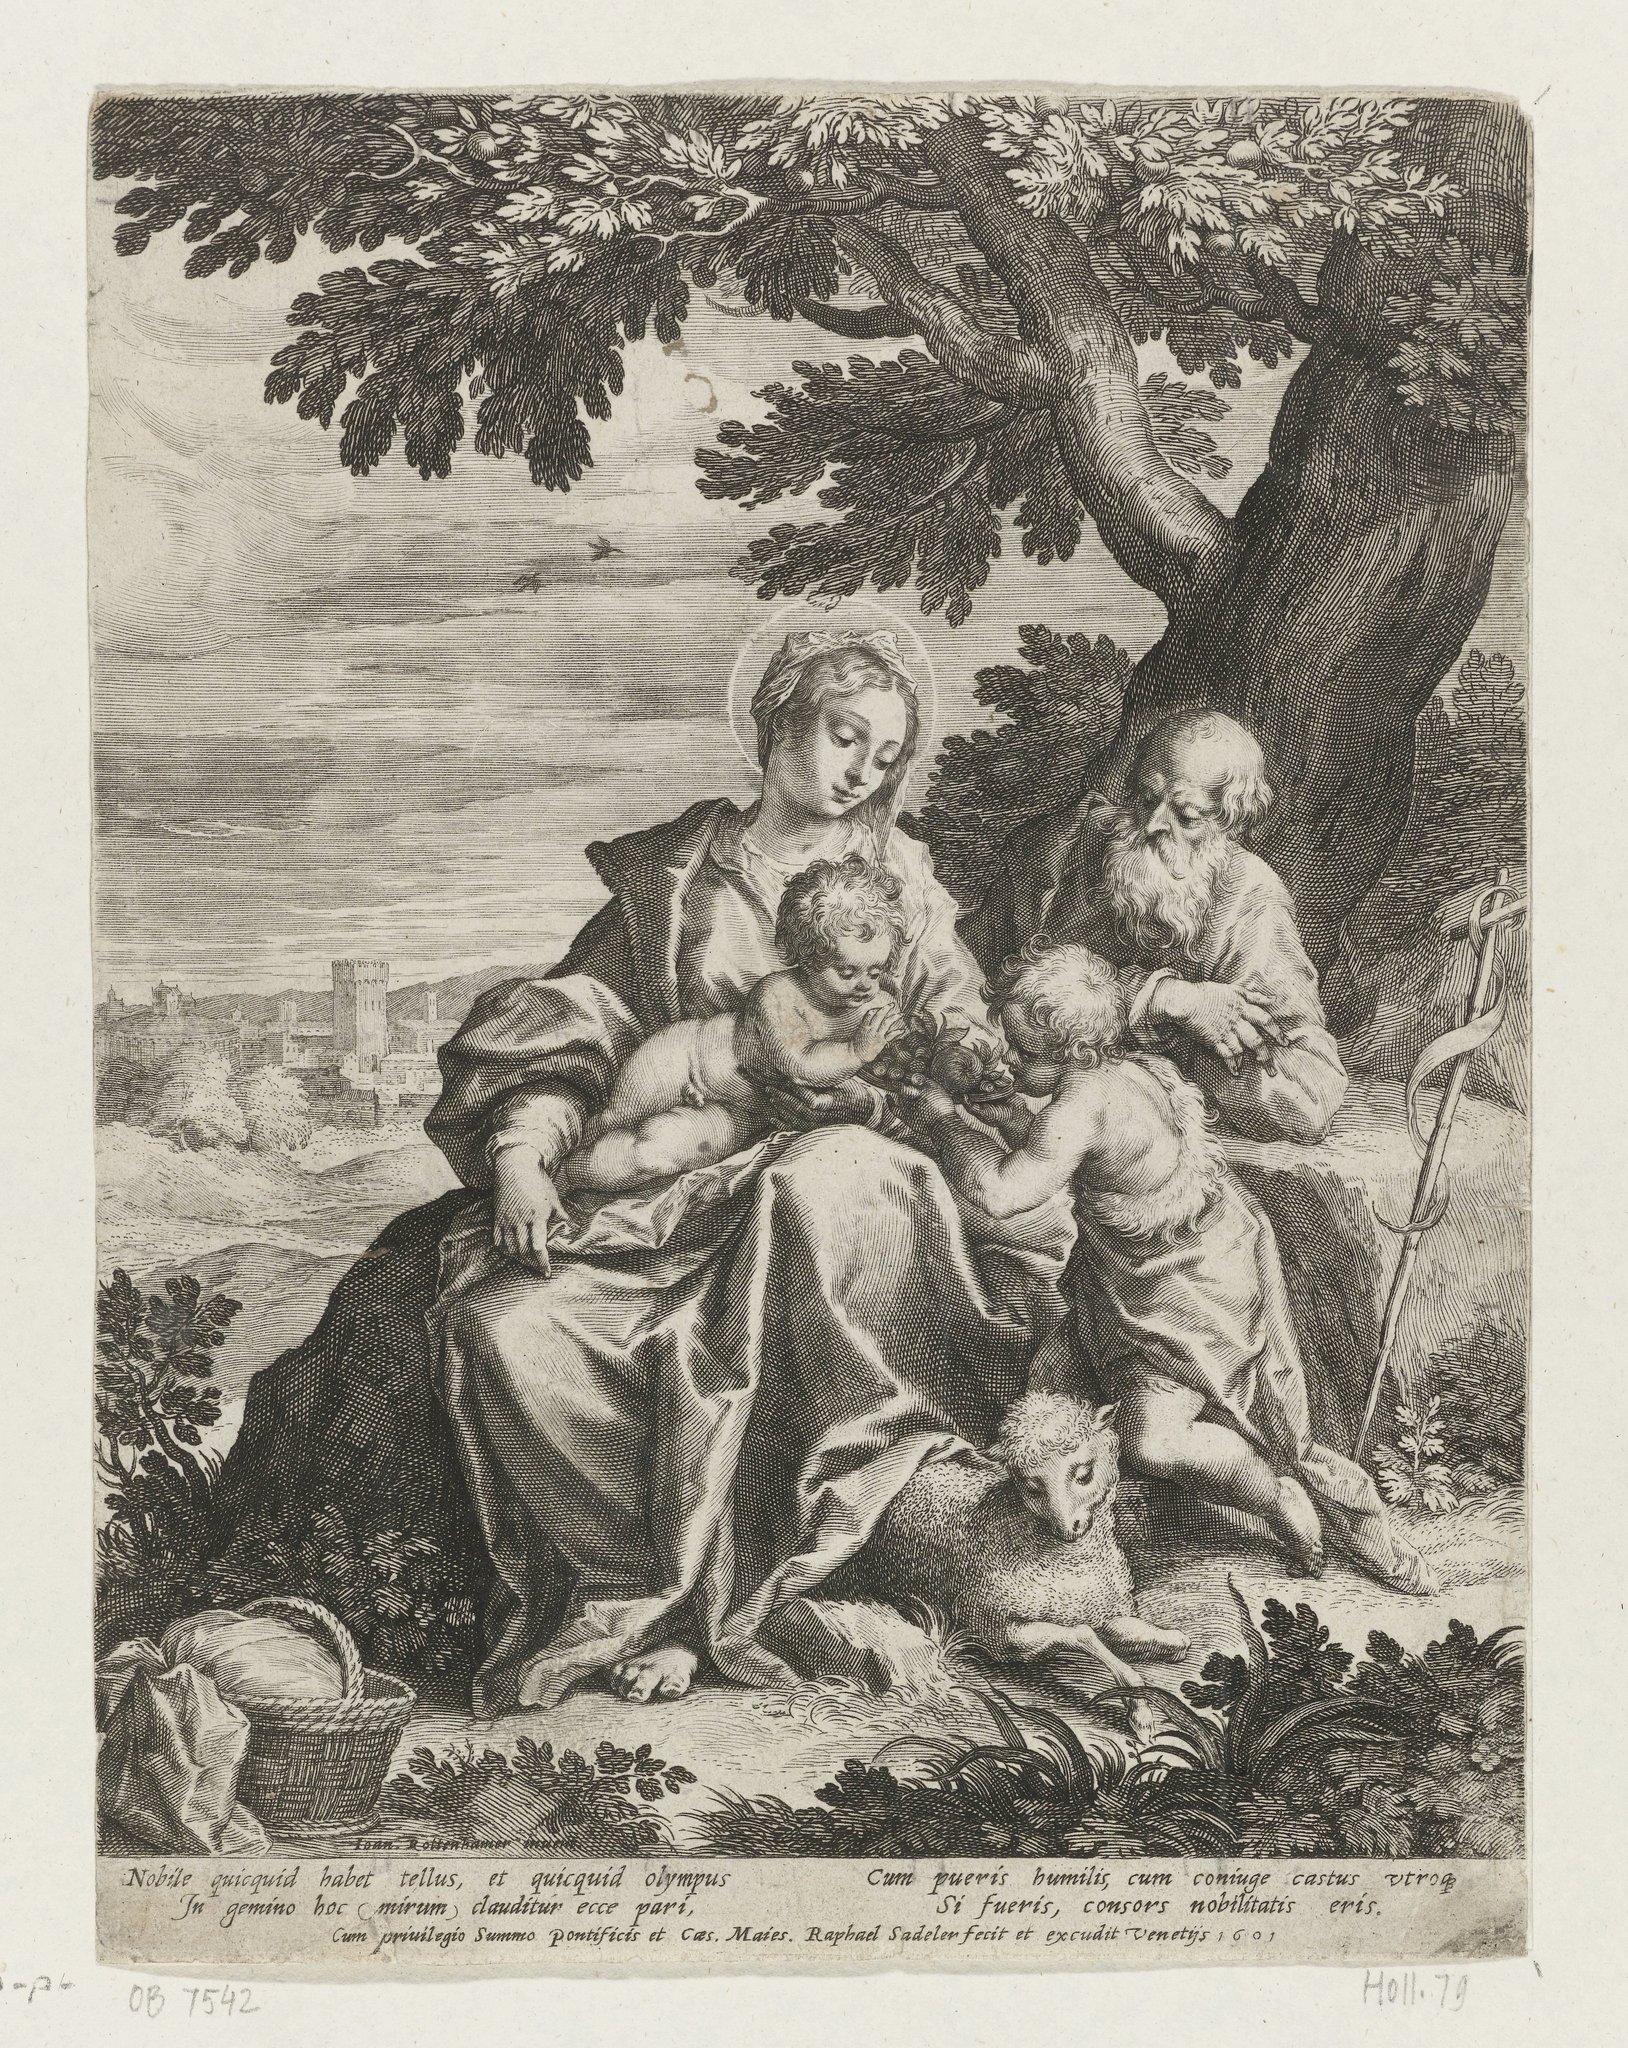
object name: print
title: Heilige Familie met Johannes de Doper in een landschap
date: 1601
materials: paper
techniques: engraving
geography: venice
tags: city-view in general; 'veduta', holy family with john the baptist (as child)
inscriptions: collector's mark: Lugt 240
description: Maria zit voor een boom, met het Christuskind op de schoot. Naast haar zit Jozef. Johannes de Doper als kind biedt Christus een schaal met fruit aan. Op de achtergrond een stad.